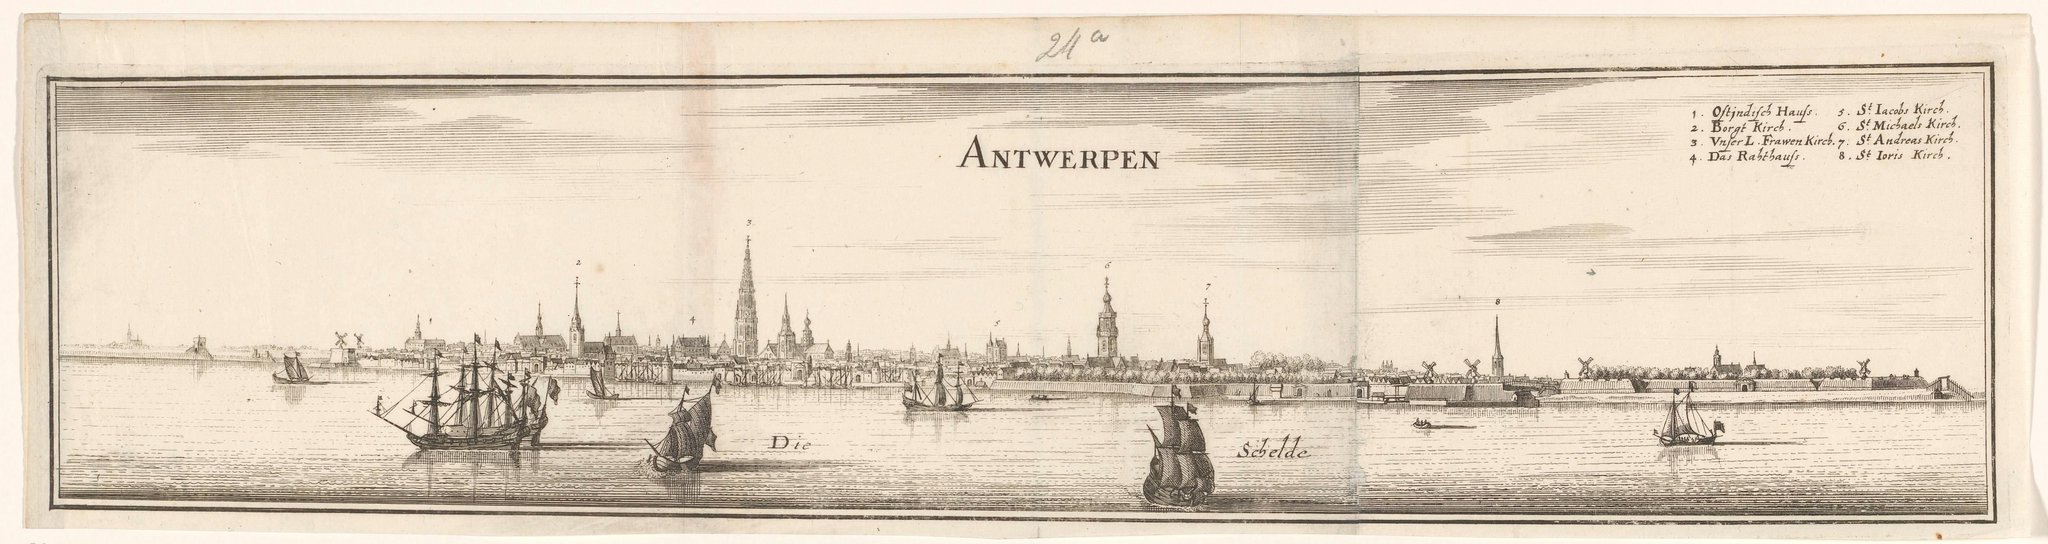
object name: print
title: Antwerpen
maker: caspar merian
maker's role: print maker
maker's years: 1627-1689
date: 1654-1700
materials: paper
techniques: engraving, etching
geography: frankfurt am main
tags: sailing-ship, sailing-boat, rowing-boat, canoe, etc., prospect of city, town panorama, silhouette of city, antwerp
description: Prent gebruikt in: Zeiller, Martin. M.Z. Topographia Circuli Burgundici Oder Beschreibung une Eigentliche Abbildung der Vornehmsten Örter in dem Hochlöblichen Burgund- un Niderlandischen Crayse. Frankfurt am Main: Caspar Merian, 1654. Of in: Zeiller, Martin. M. Z. Topographia Germaniae-Inferioris vel Circuli-Burgundici, das ist Beschreibung (…). Frankfurt am Main: Caspar Merian, 1659. Of in een van de twee latere uitgaven van deze publicatie die, hoewel het jaar 1659 erin staat vermeld als jaar van uitgave, zijn uitgegeven in respectievelijk ca. 1670 en ca. 1700.